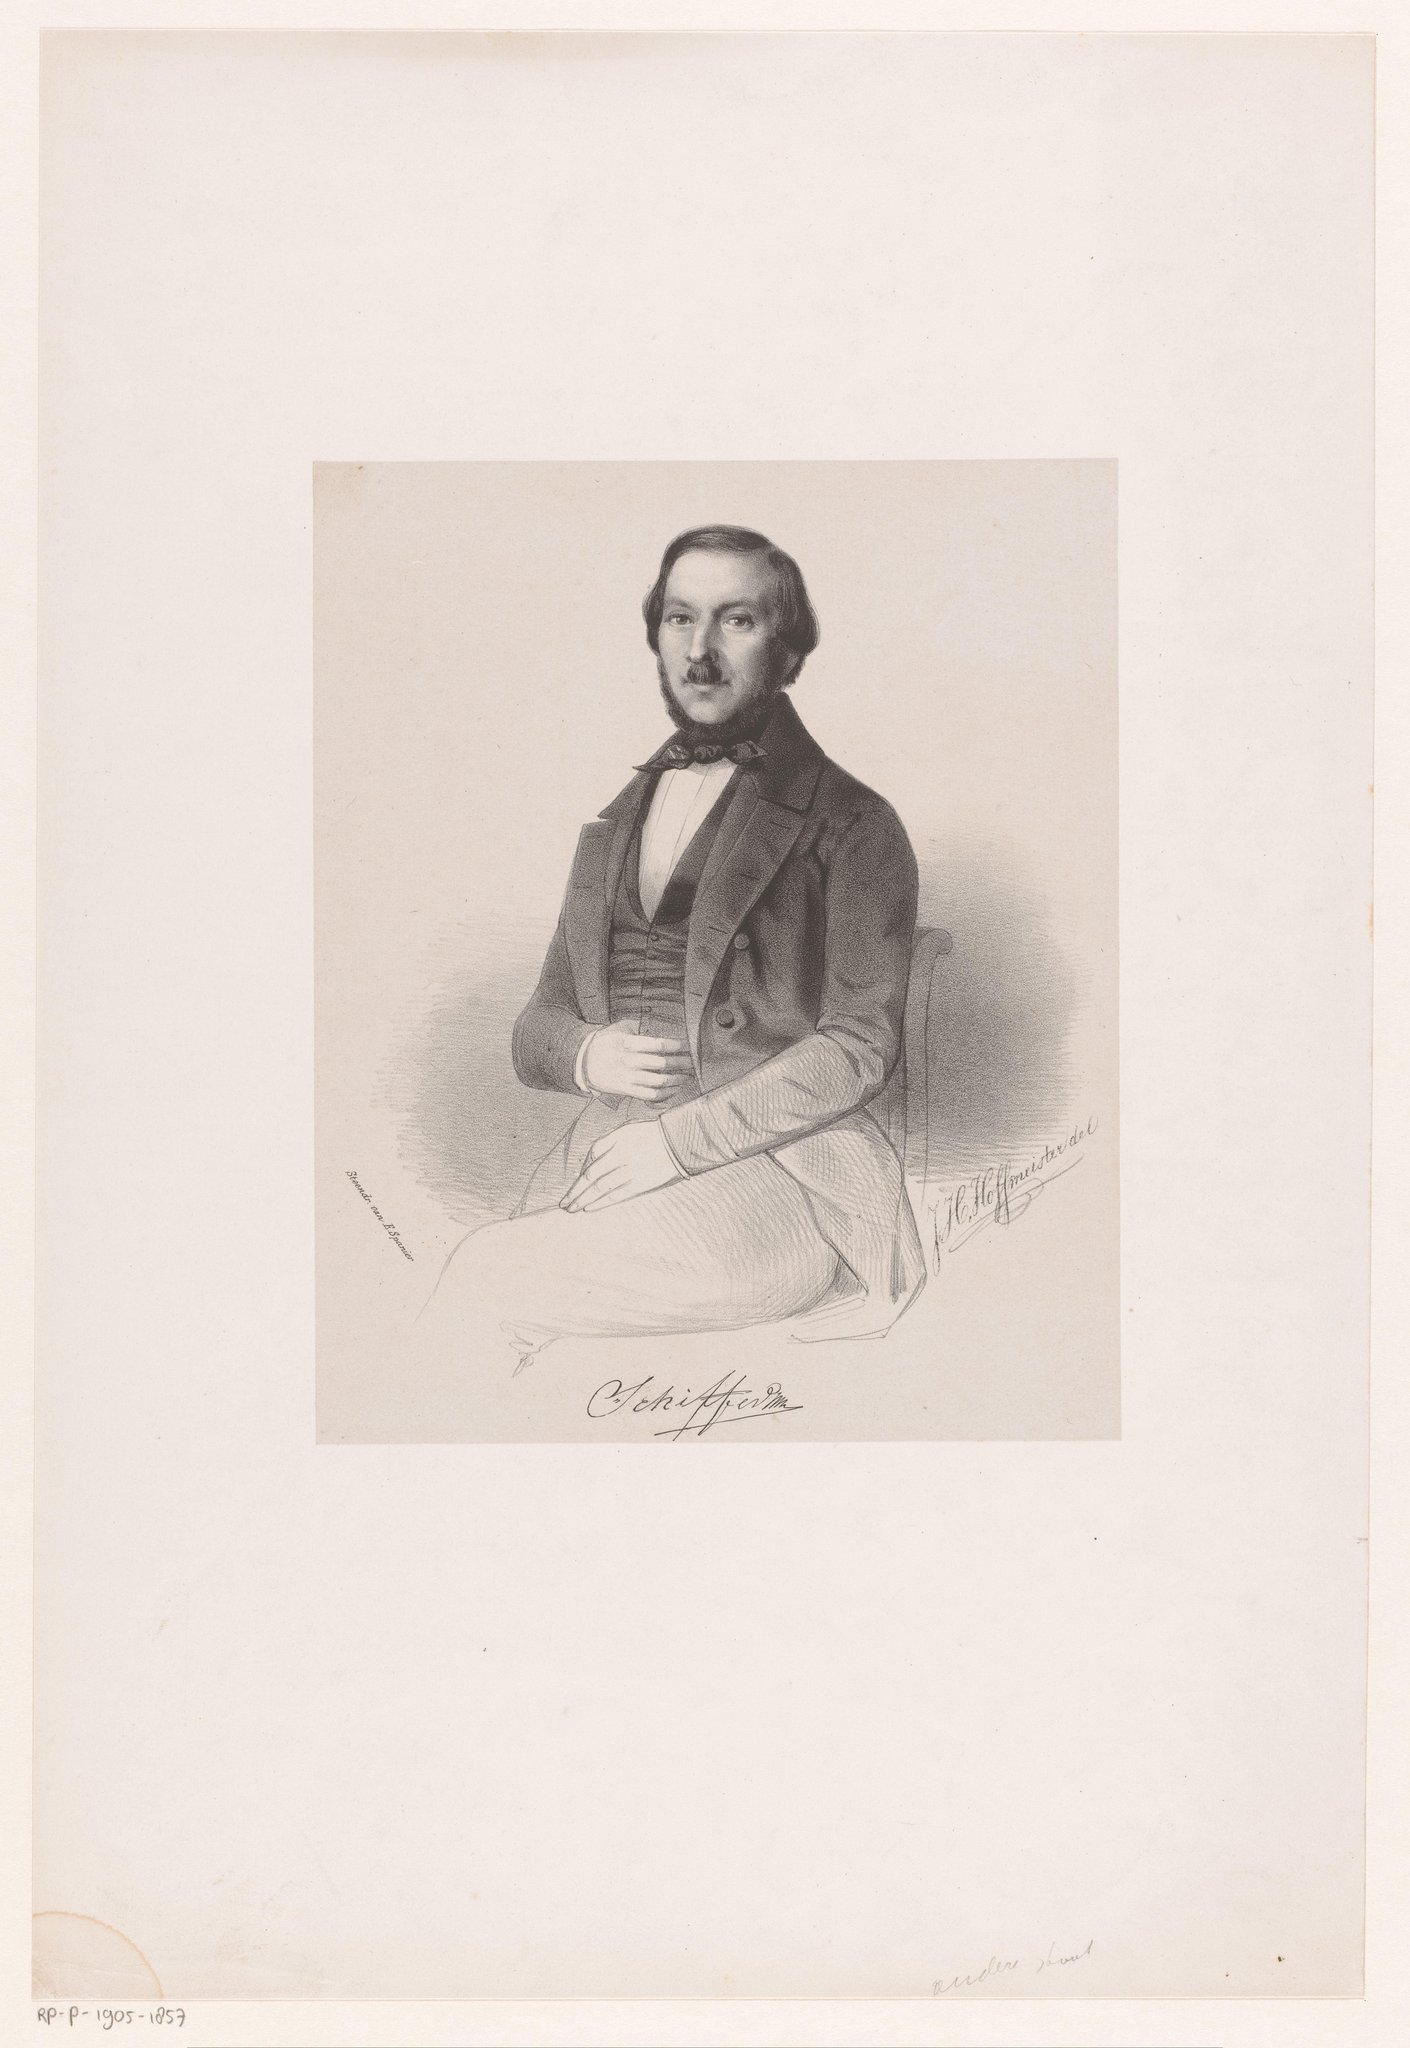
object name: print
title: Portret van Cornelis Schiffer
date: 1833-1891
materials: paper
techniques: lithograph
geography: the hague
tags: historical persons (+ three-quarter length portrait)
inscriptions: collector's mark: Lugt 2228